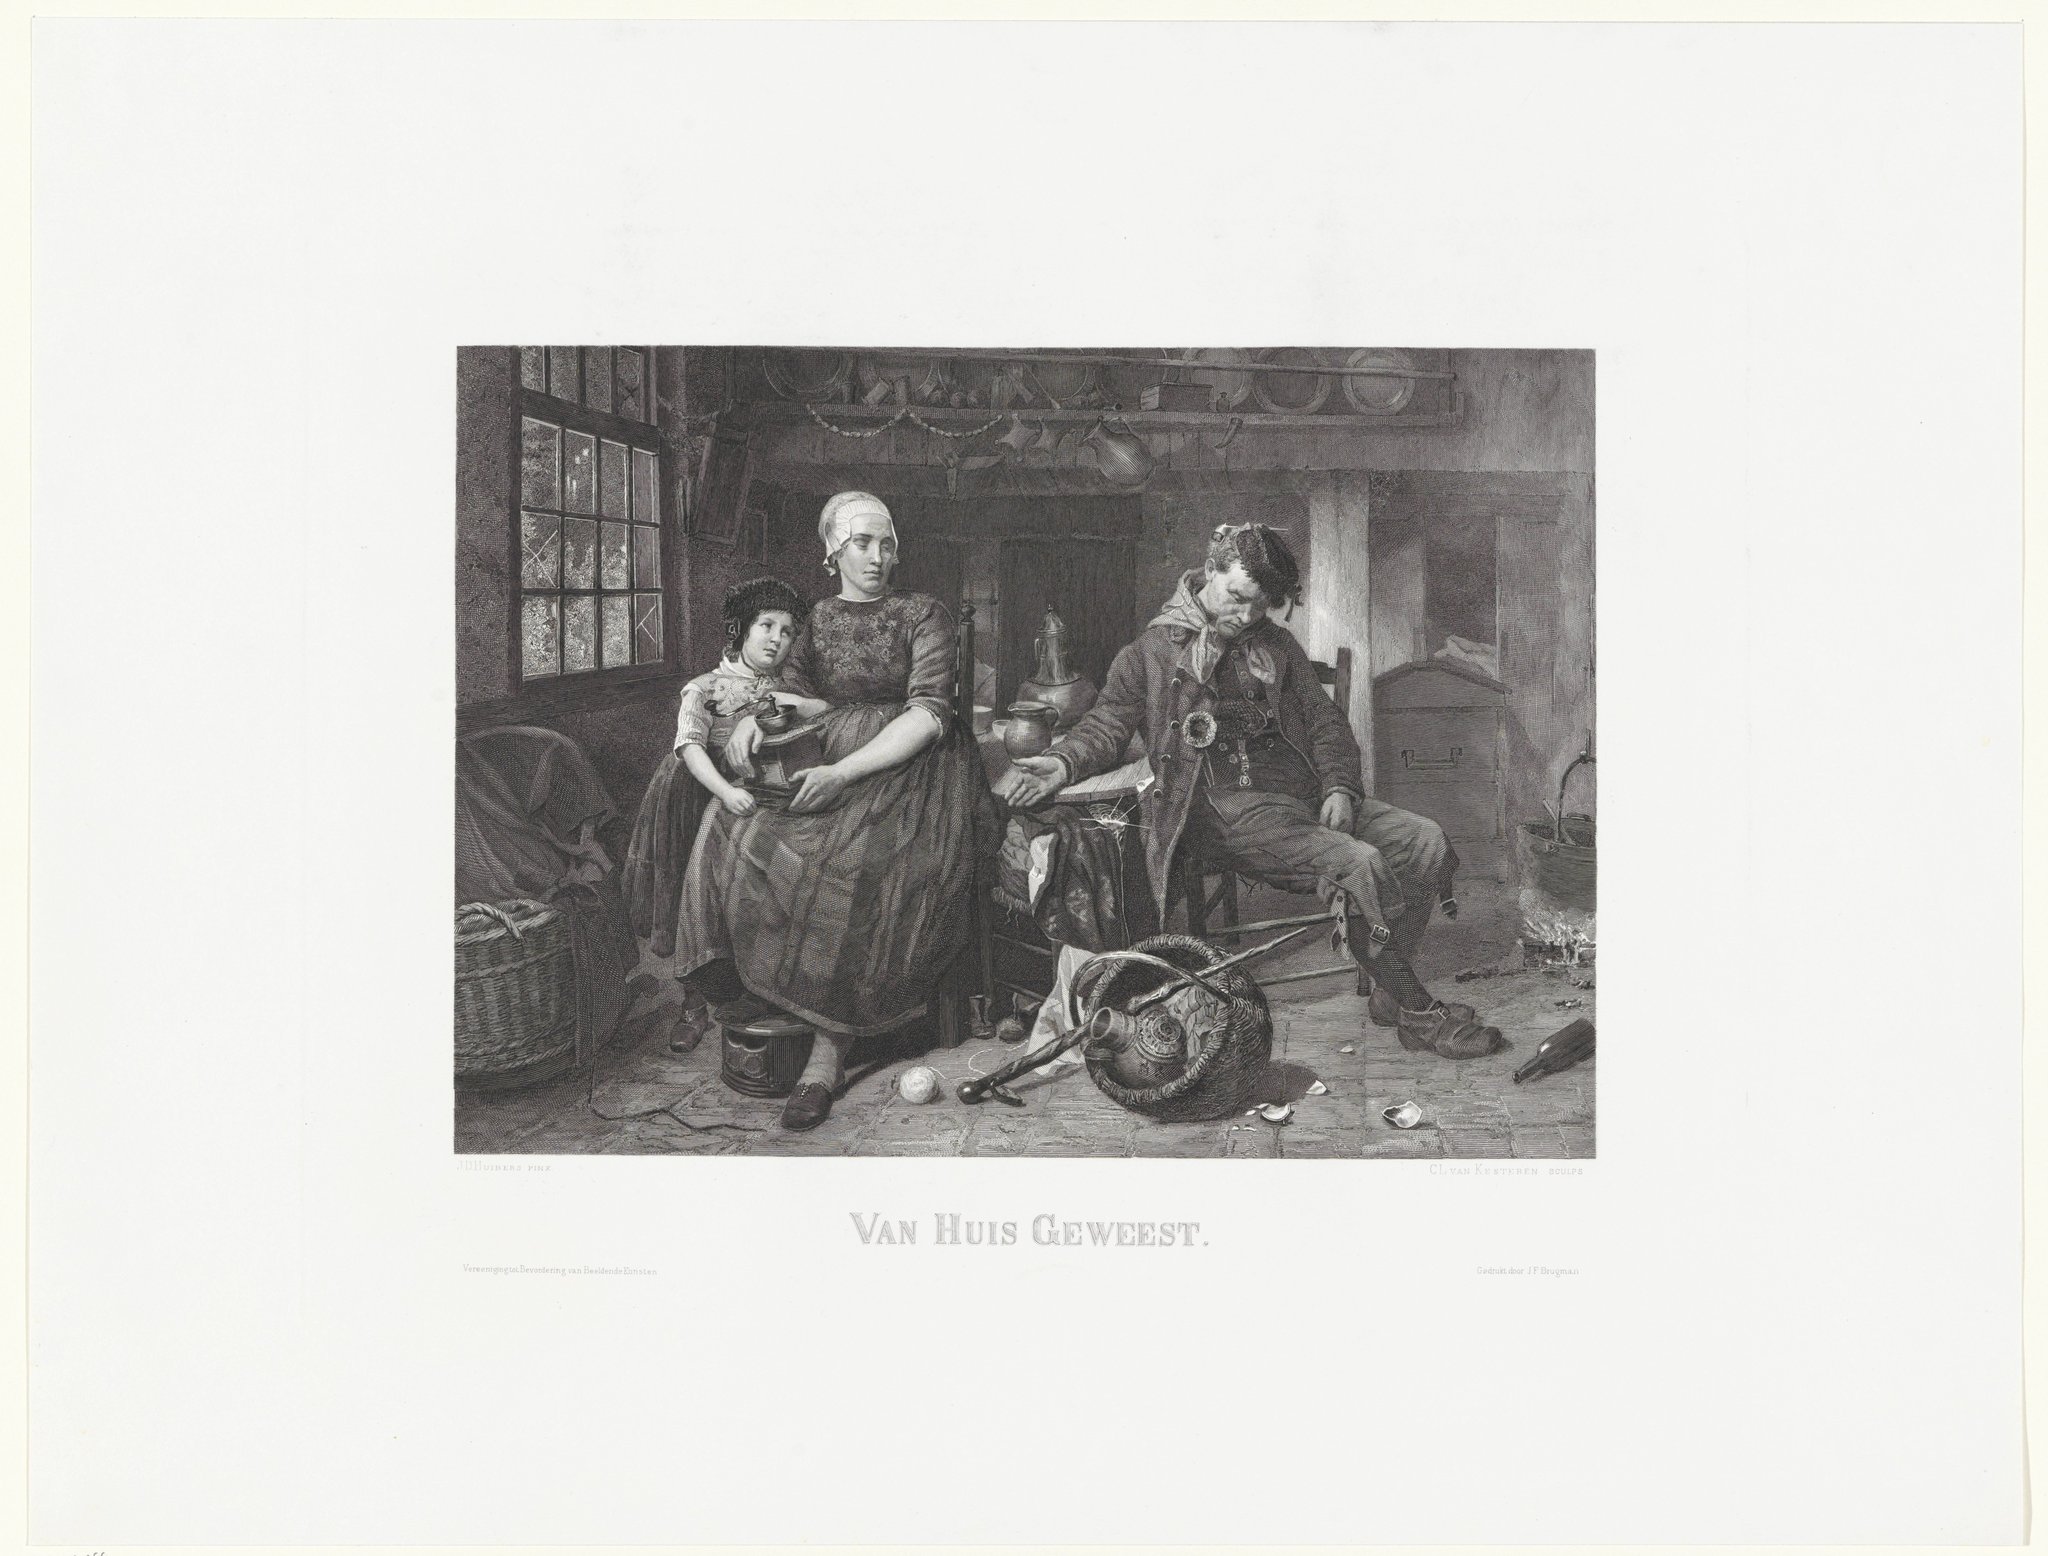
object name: print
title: Van Huis Geweest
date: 1842-1879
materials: paper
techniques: engraving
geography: netherlands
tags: family, descendance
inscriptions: collector's mark: Lugt 2228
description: In een rommelig vertrek zitten een vrouw met haar kind en een man bij een tafel. De man heeft zijn hand naar de vrouw uitgestoken, maar zij houdt haar handen op een koffiemolen.